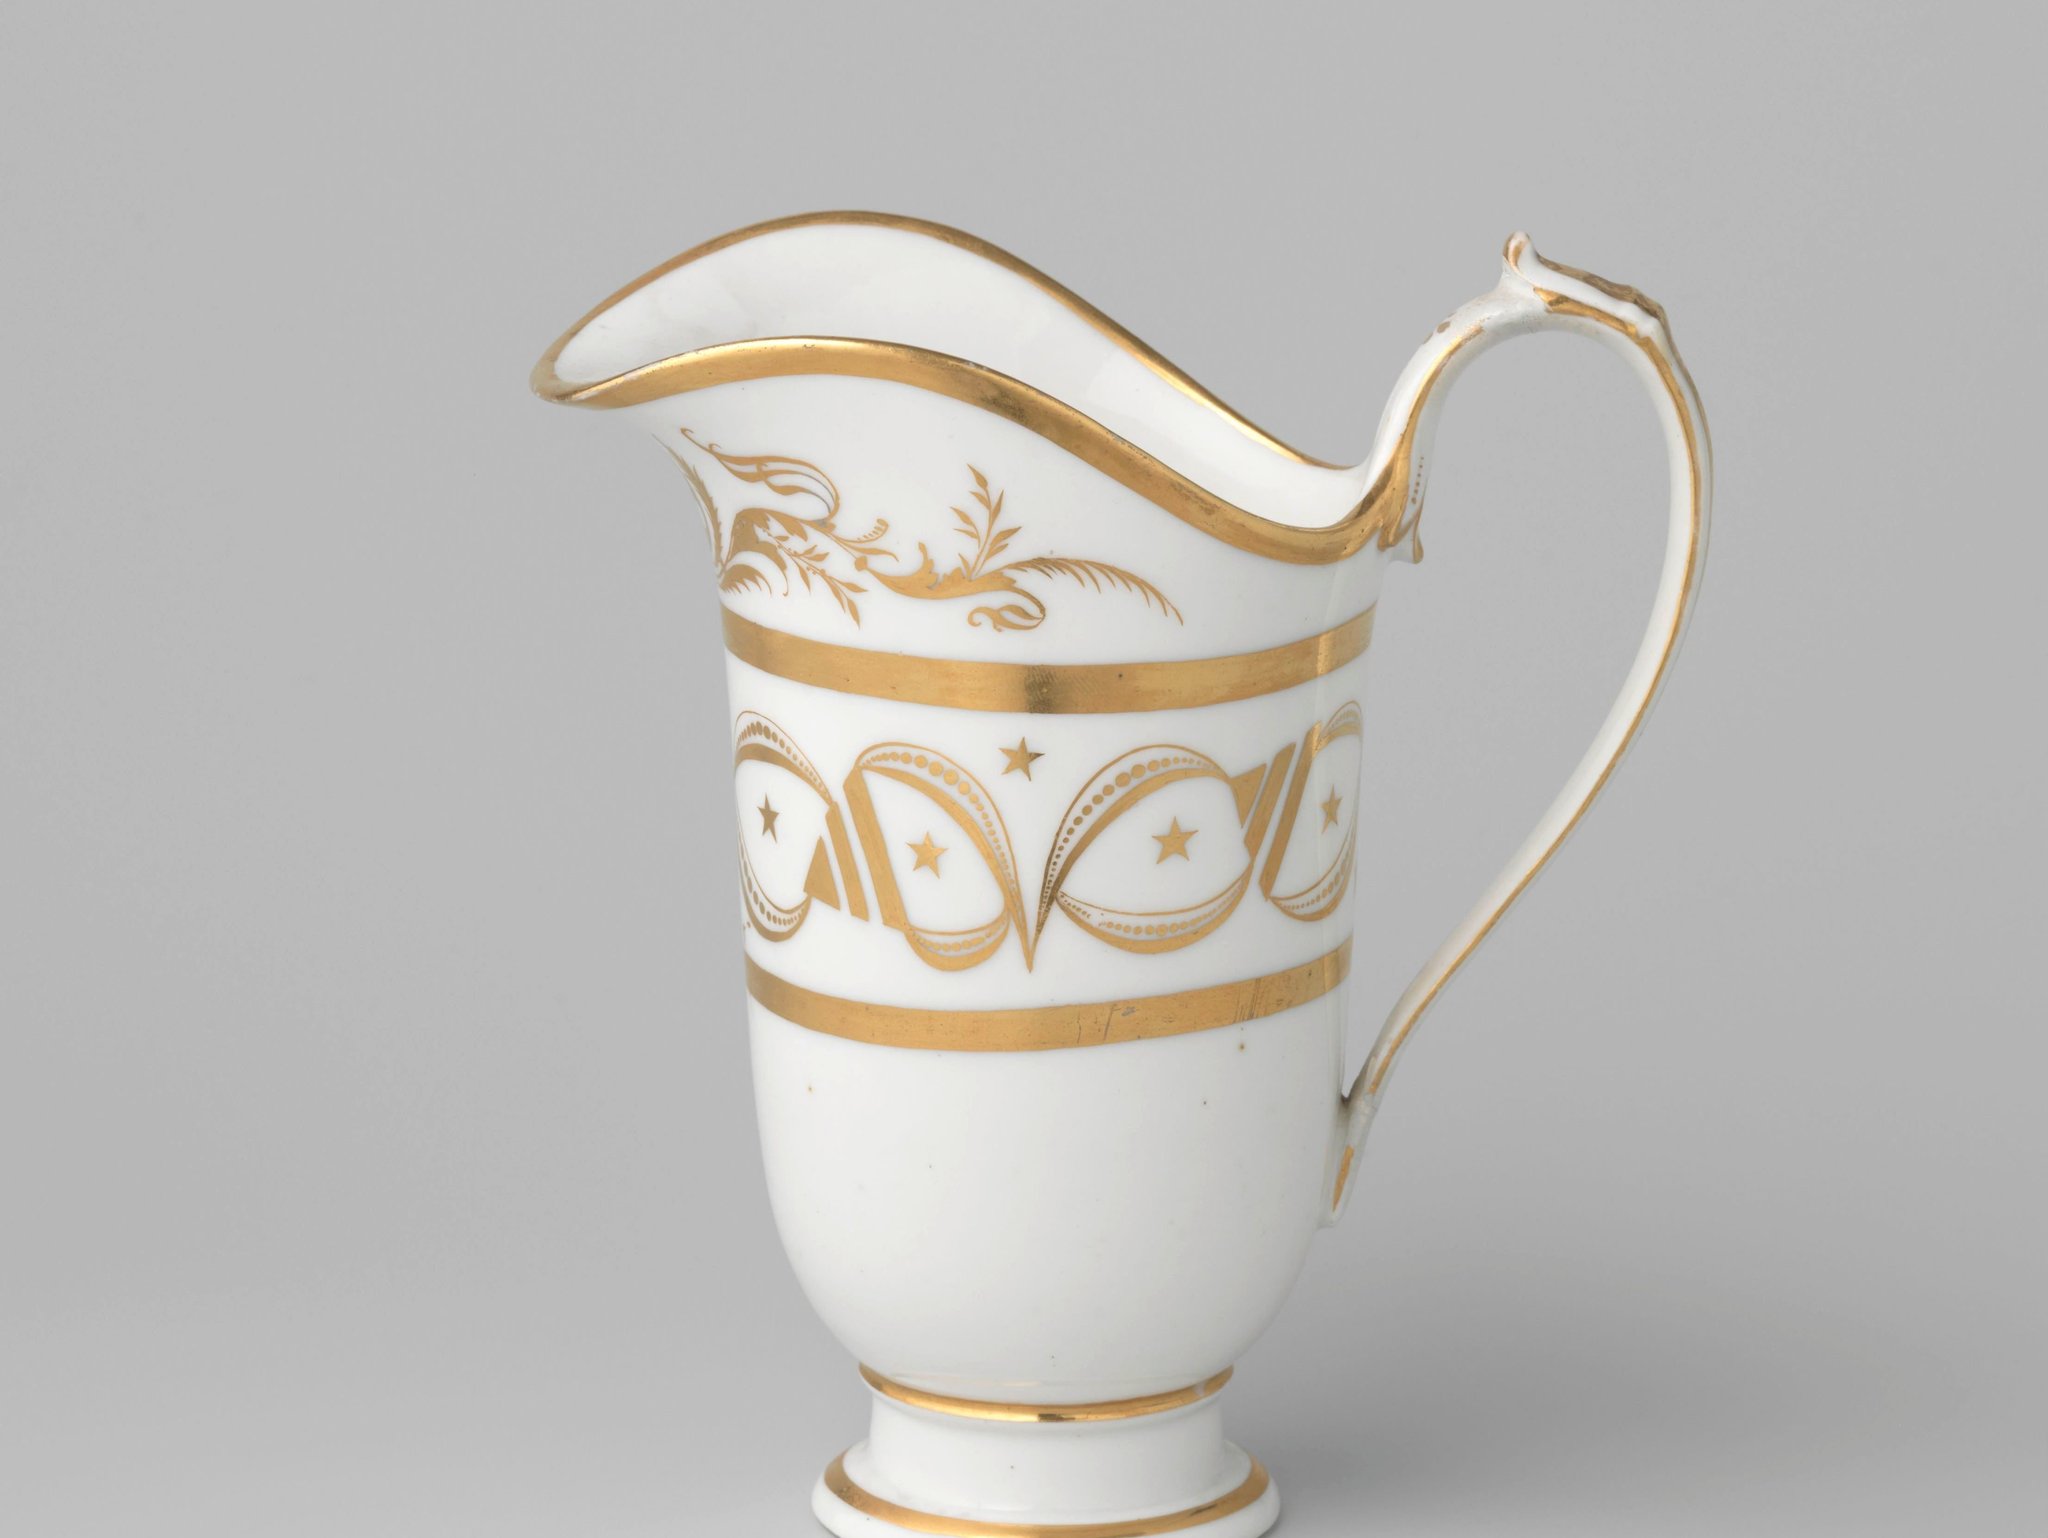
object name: service set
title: Melkkan with floral scrolls and ornamental borders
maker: Anonymous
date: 1800-1824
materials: glaze, gold, paint, porcelain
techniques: firing, forming, gilding, turning, vitrification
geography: france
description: Melkkan van porselein, beschilderd op het glazuur in goud. De kan heeft een cilindrisch lichaam, afgerond naar de spreidende voet en een breed uitlopende schenkrand aan één zijde. Het C-vormige oor ontspringt vanuit de lage zijde van de rand. Het lichaam is met gouden lijnen verdeeld in drie brede banden met in de middelste een slinger van sterren, halve maanvormen met stippen en driehoeken. Onder de rand een bloemrank. Het oor is bij de rand gemodelleerd en versierd met gestileerde bloemen. Empire.